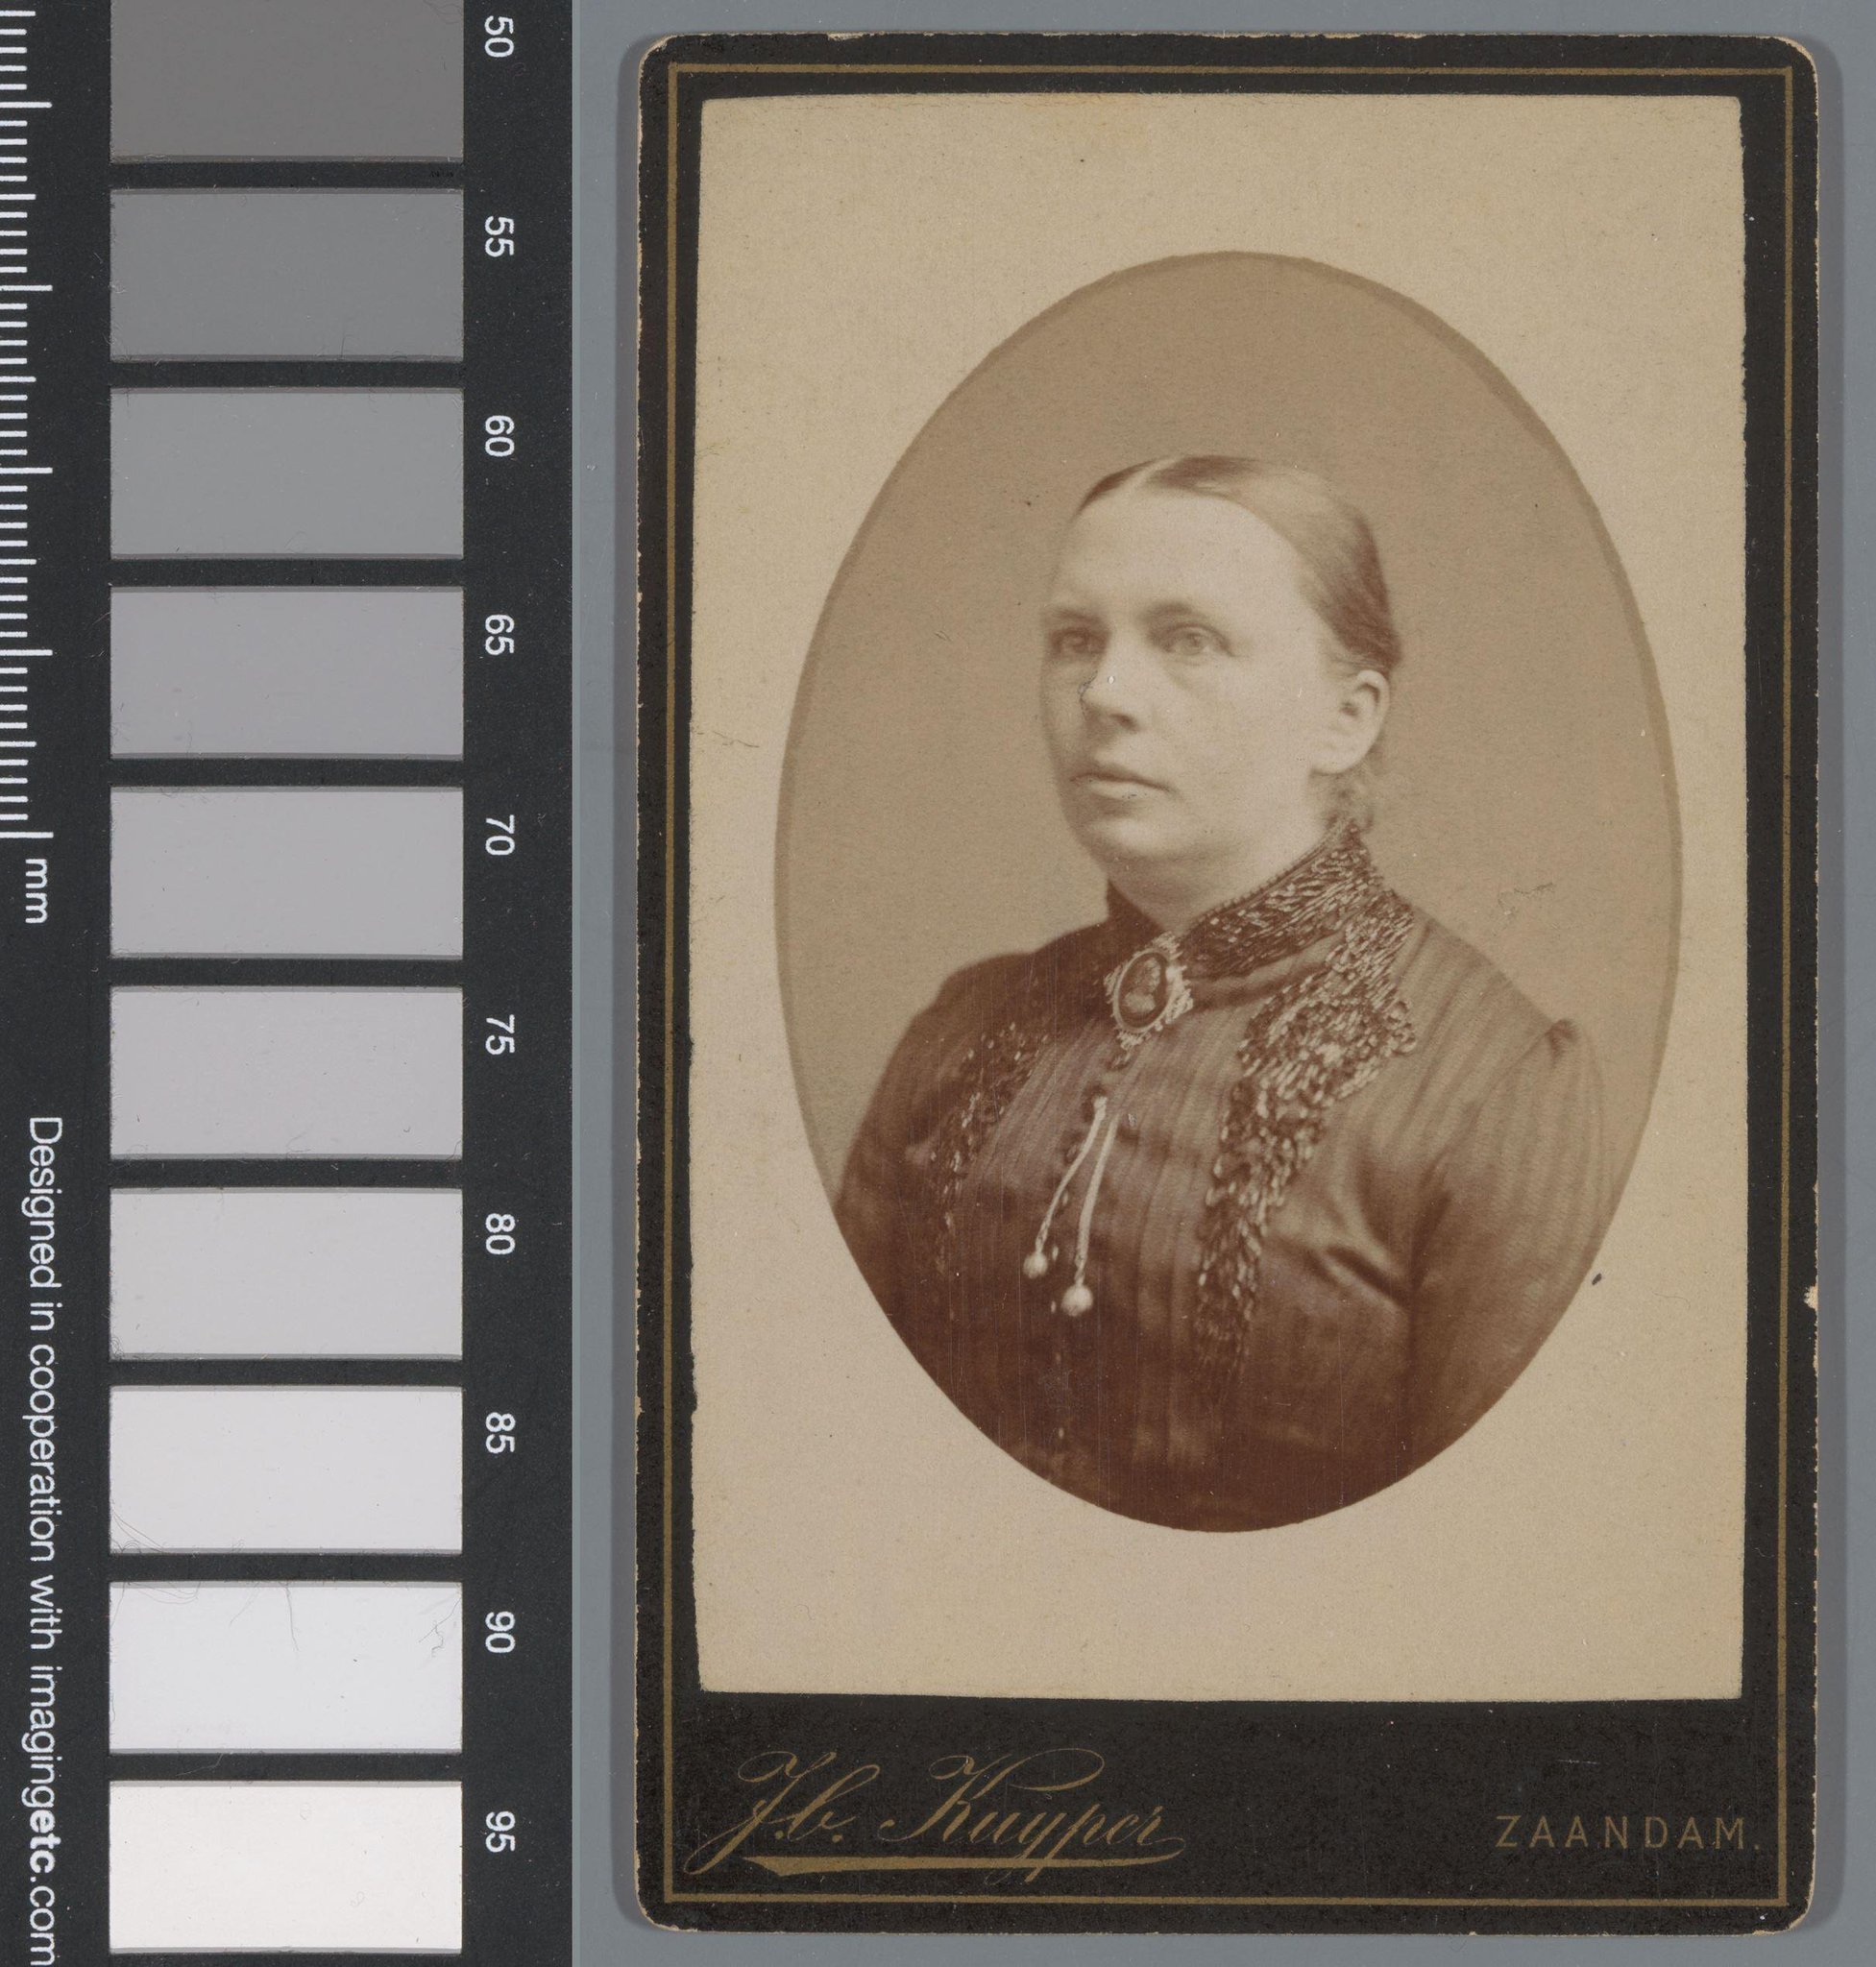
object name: photograph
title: Portret van een onbekende vrouw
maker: jacob kuyper (1851-1919)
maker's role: fotograaf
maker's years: 1851-1919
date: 1878-1885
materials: cardboard, paper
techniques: albumen print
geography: zaandam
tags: adult woman, anonymous historical person portrayed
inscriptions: inscription: ‘Voor nabesteling wordt de origineele plaat/ bewaard./ Vergrooting naar alle bestaande Photographien.’, address: ‘Zaandam/ westzijde bij de kerk/ Noorderkerkpad.’